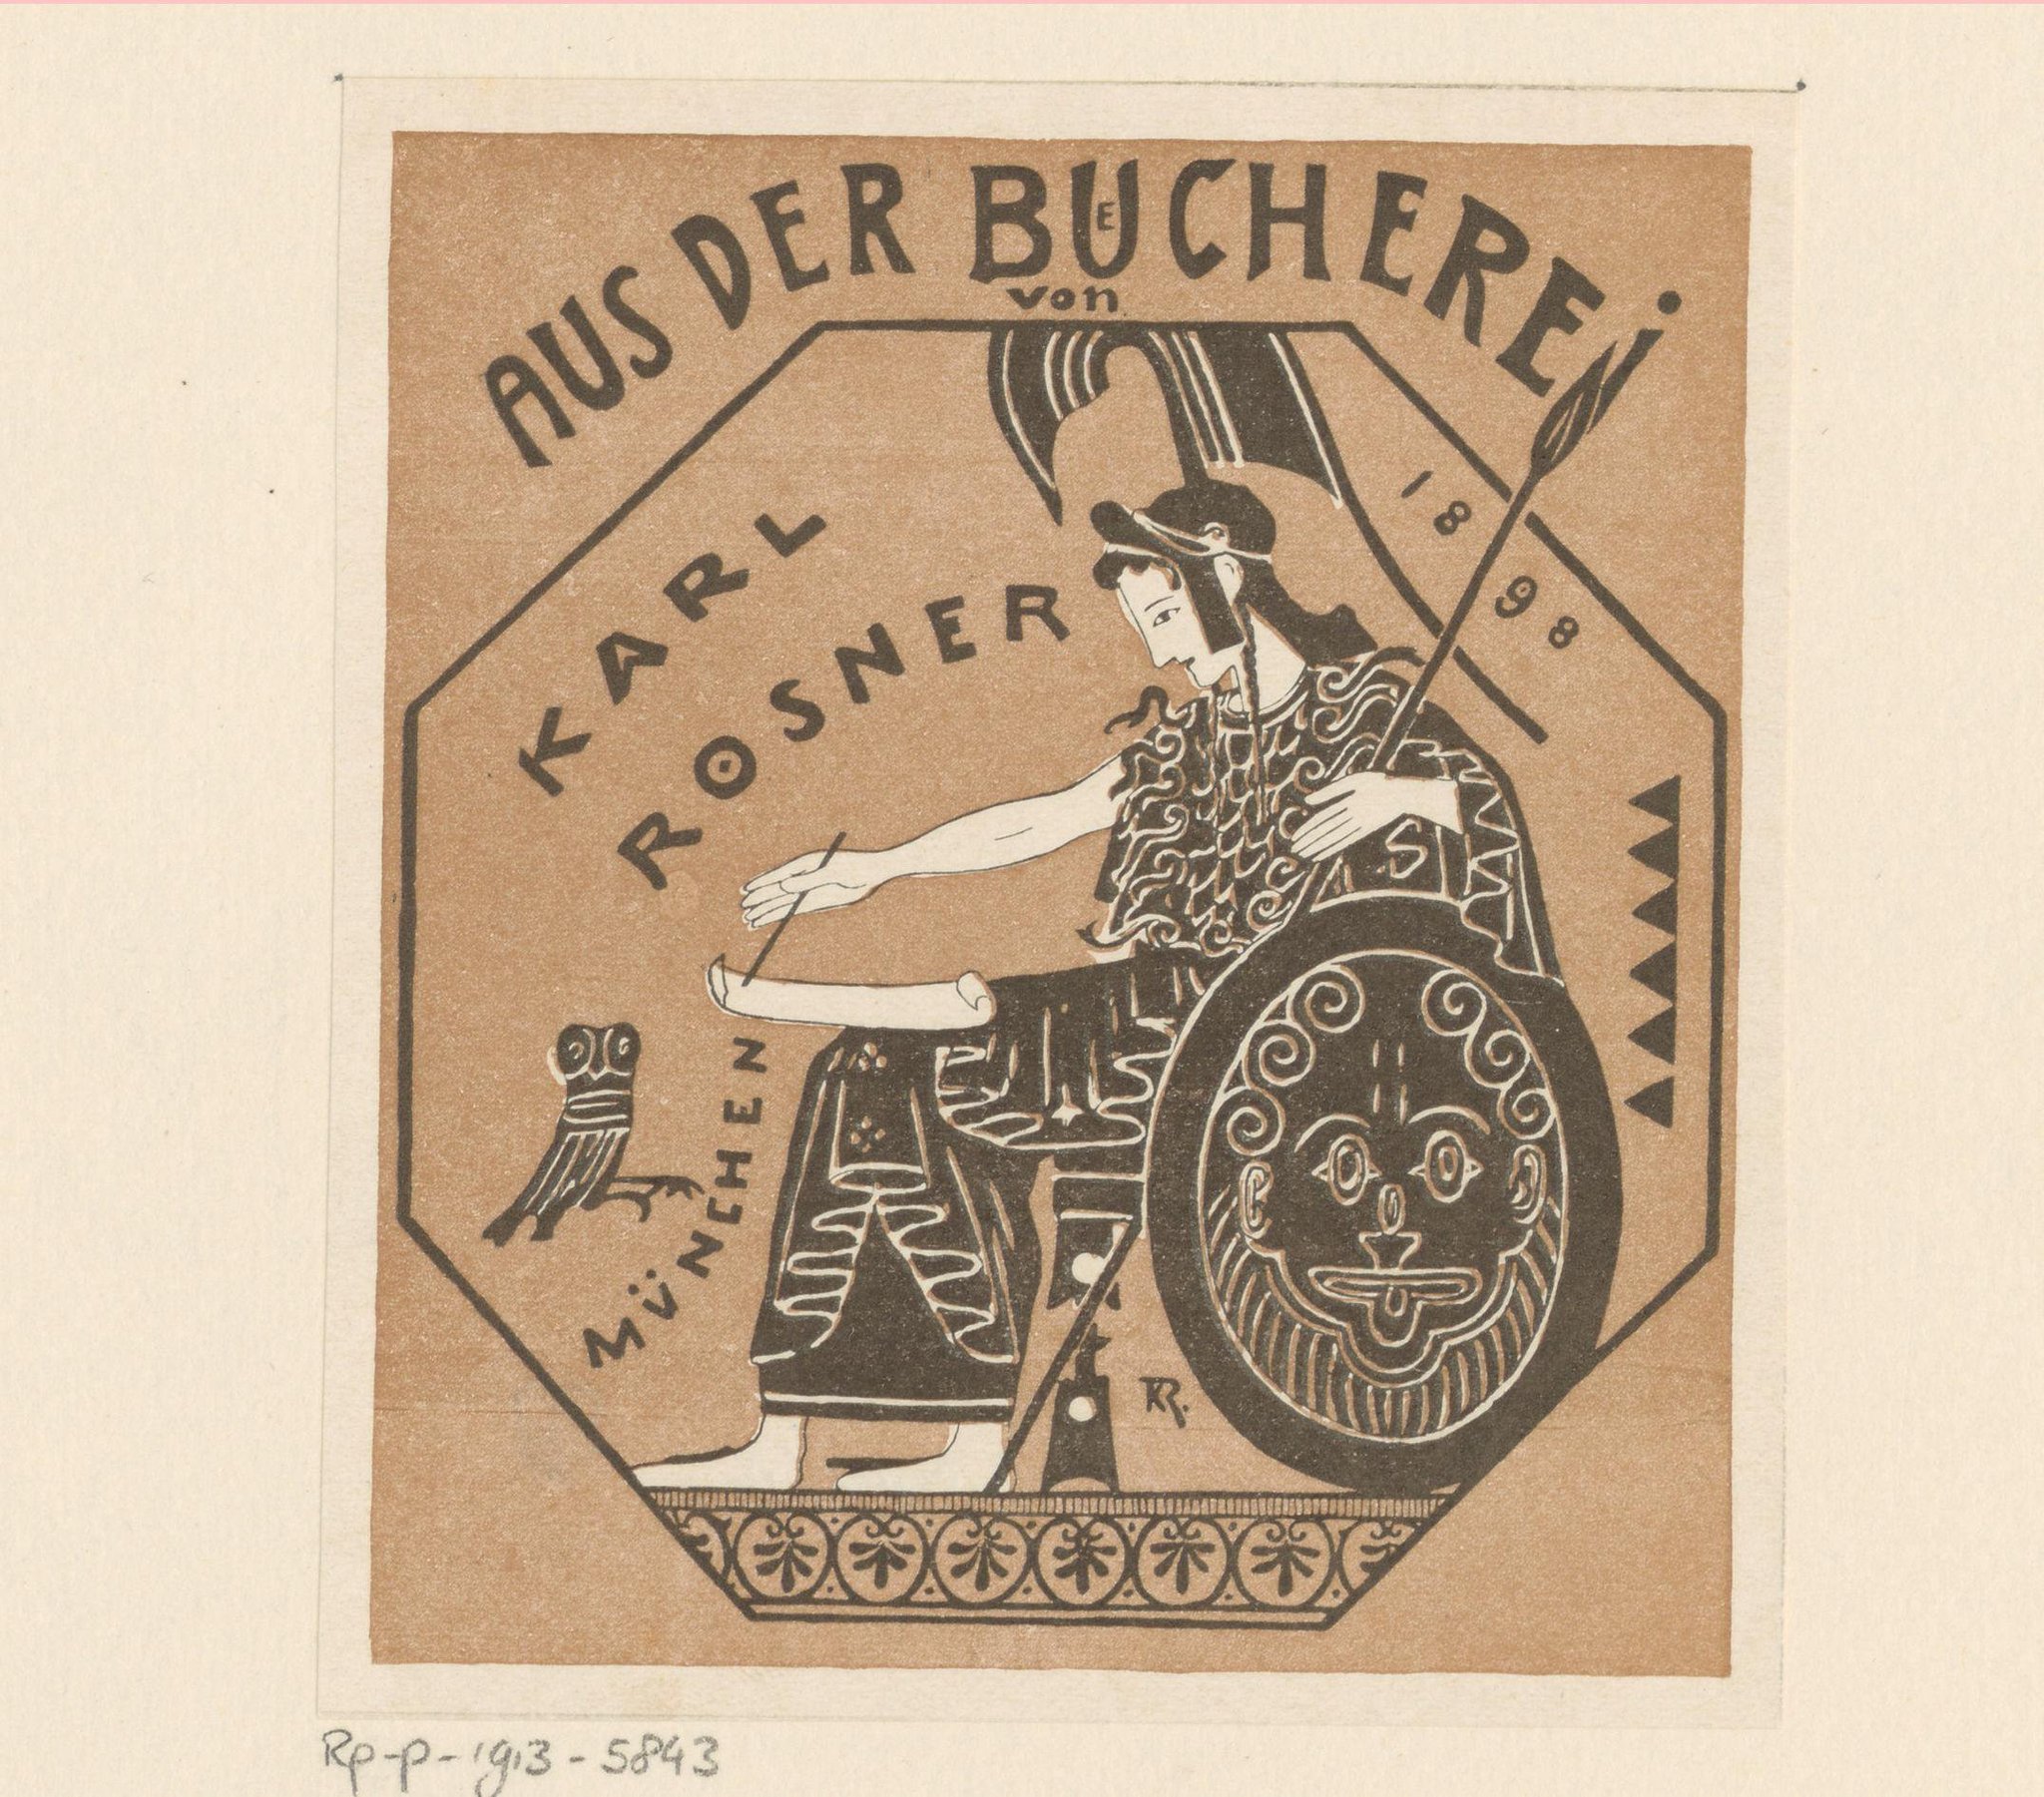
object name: bookplate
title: Ex libris van Karl Rosner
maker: Anonymous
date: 1898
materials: paper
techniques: printing block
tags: vienna, berlin, specific aspects, allegorical aspects of minerva; minerva as patroness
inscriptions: monogram: ‘KR’, collector's mark: Lugt 2233, collector's mark: Lugt 2760